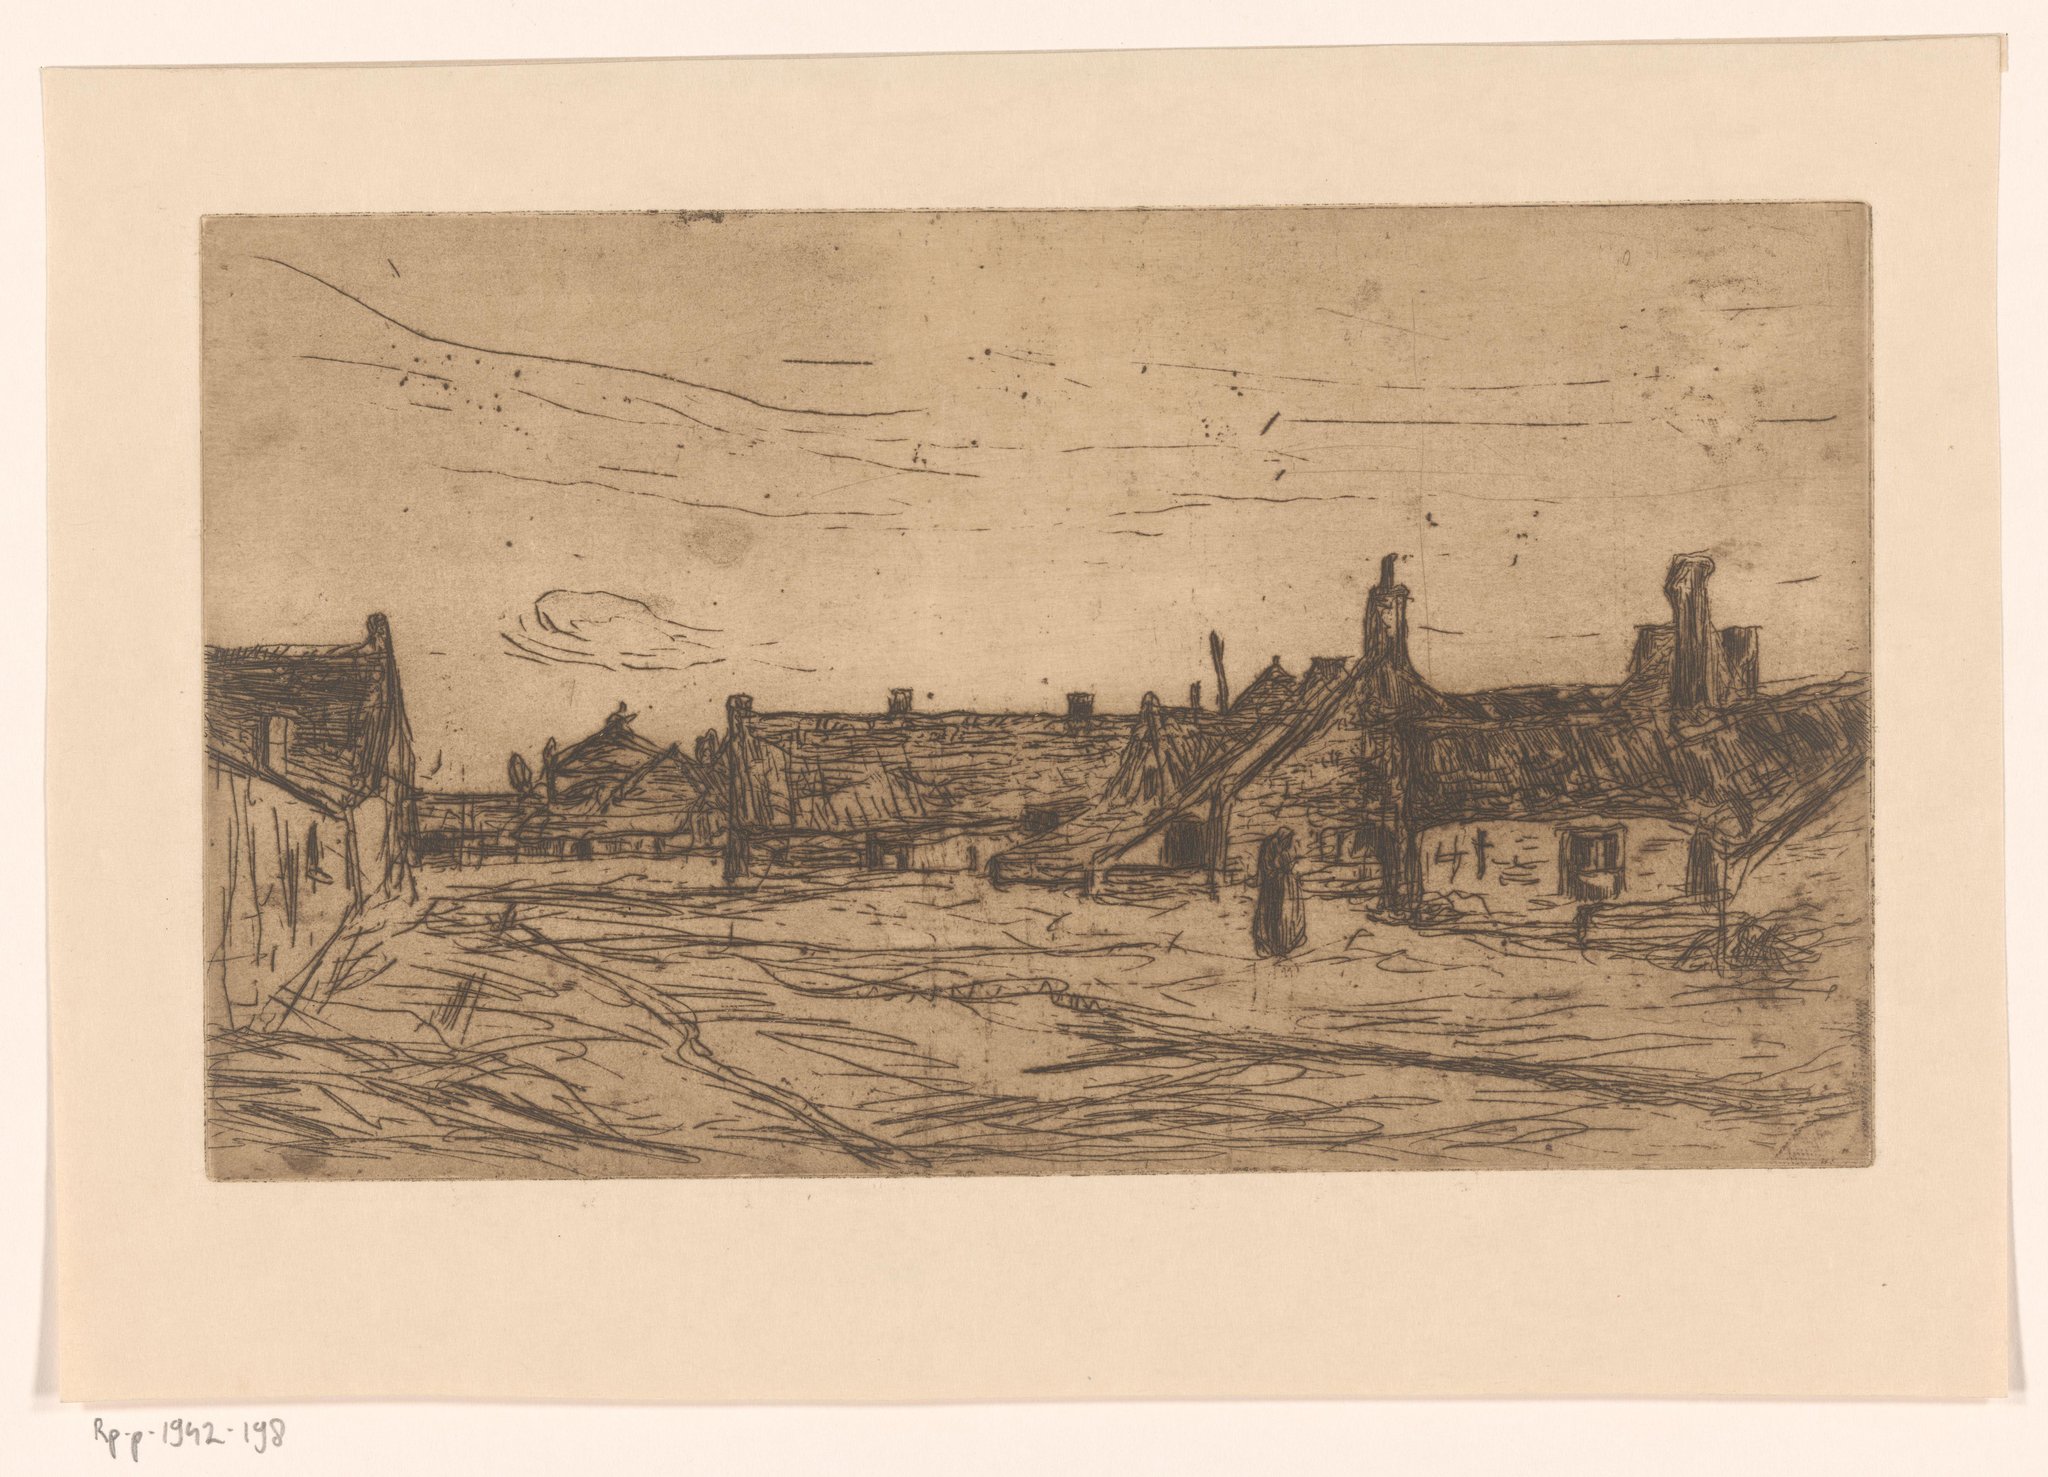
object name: print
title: Gezicht op Katwijk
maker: floris verster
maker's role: draughtsman, painter, print maker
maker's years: 1861-1927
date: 1888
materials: paper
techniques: etching, intaglio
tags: prospect of village, silhouette of village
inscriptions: collector's mark: Lugt 2760, collector's mark: Lugt 2228